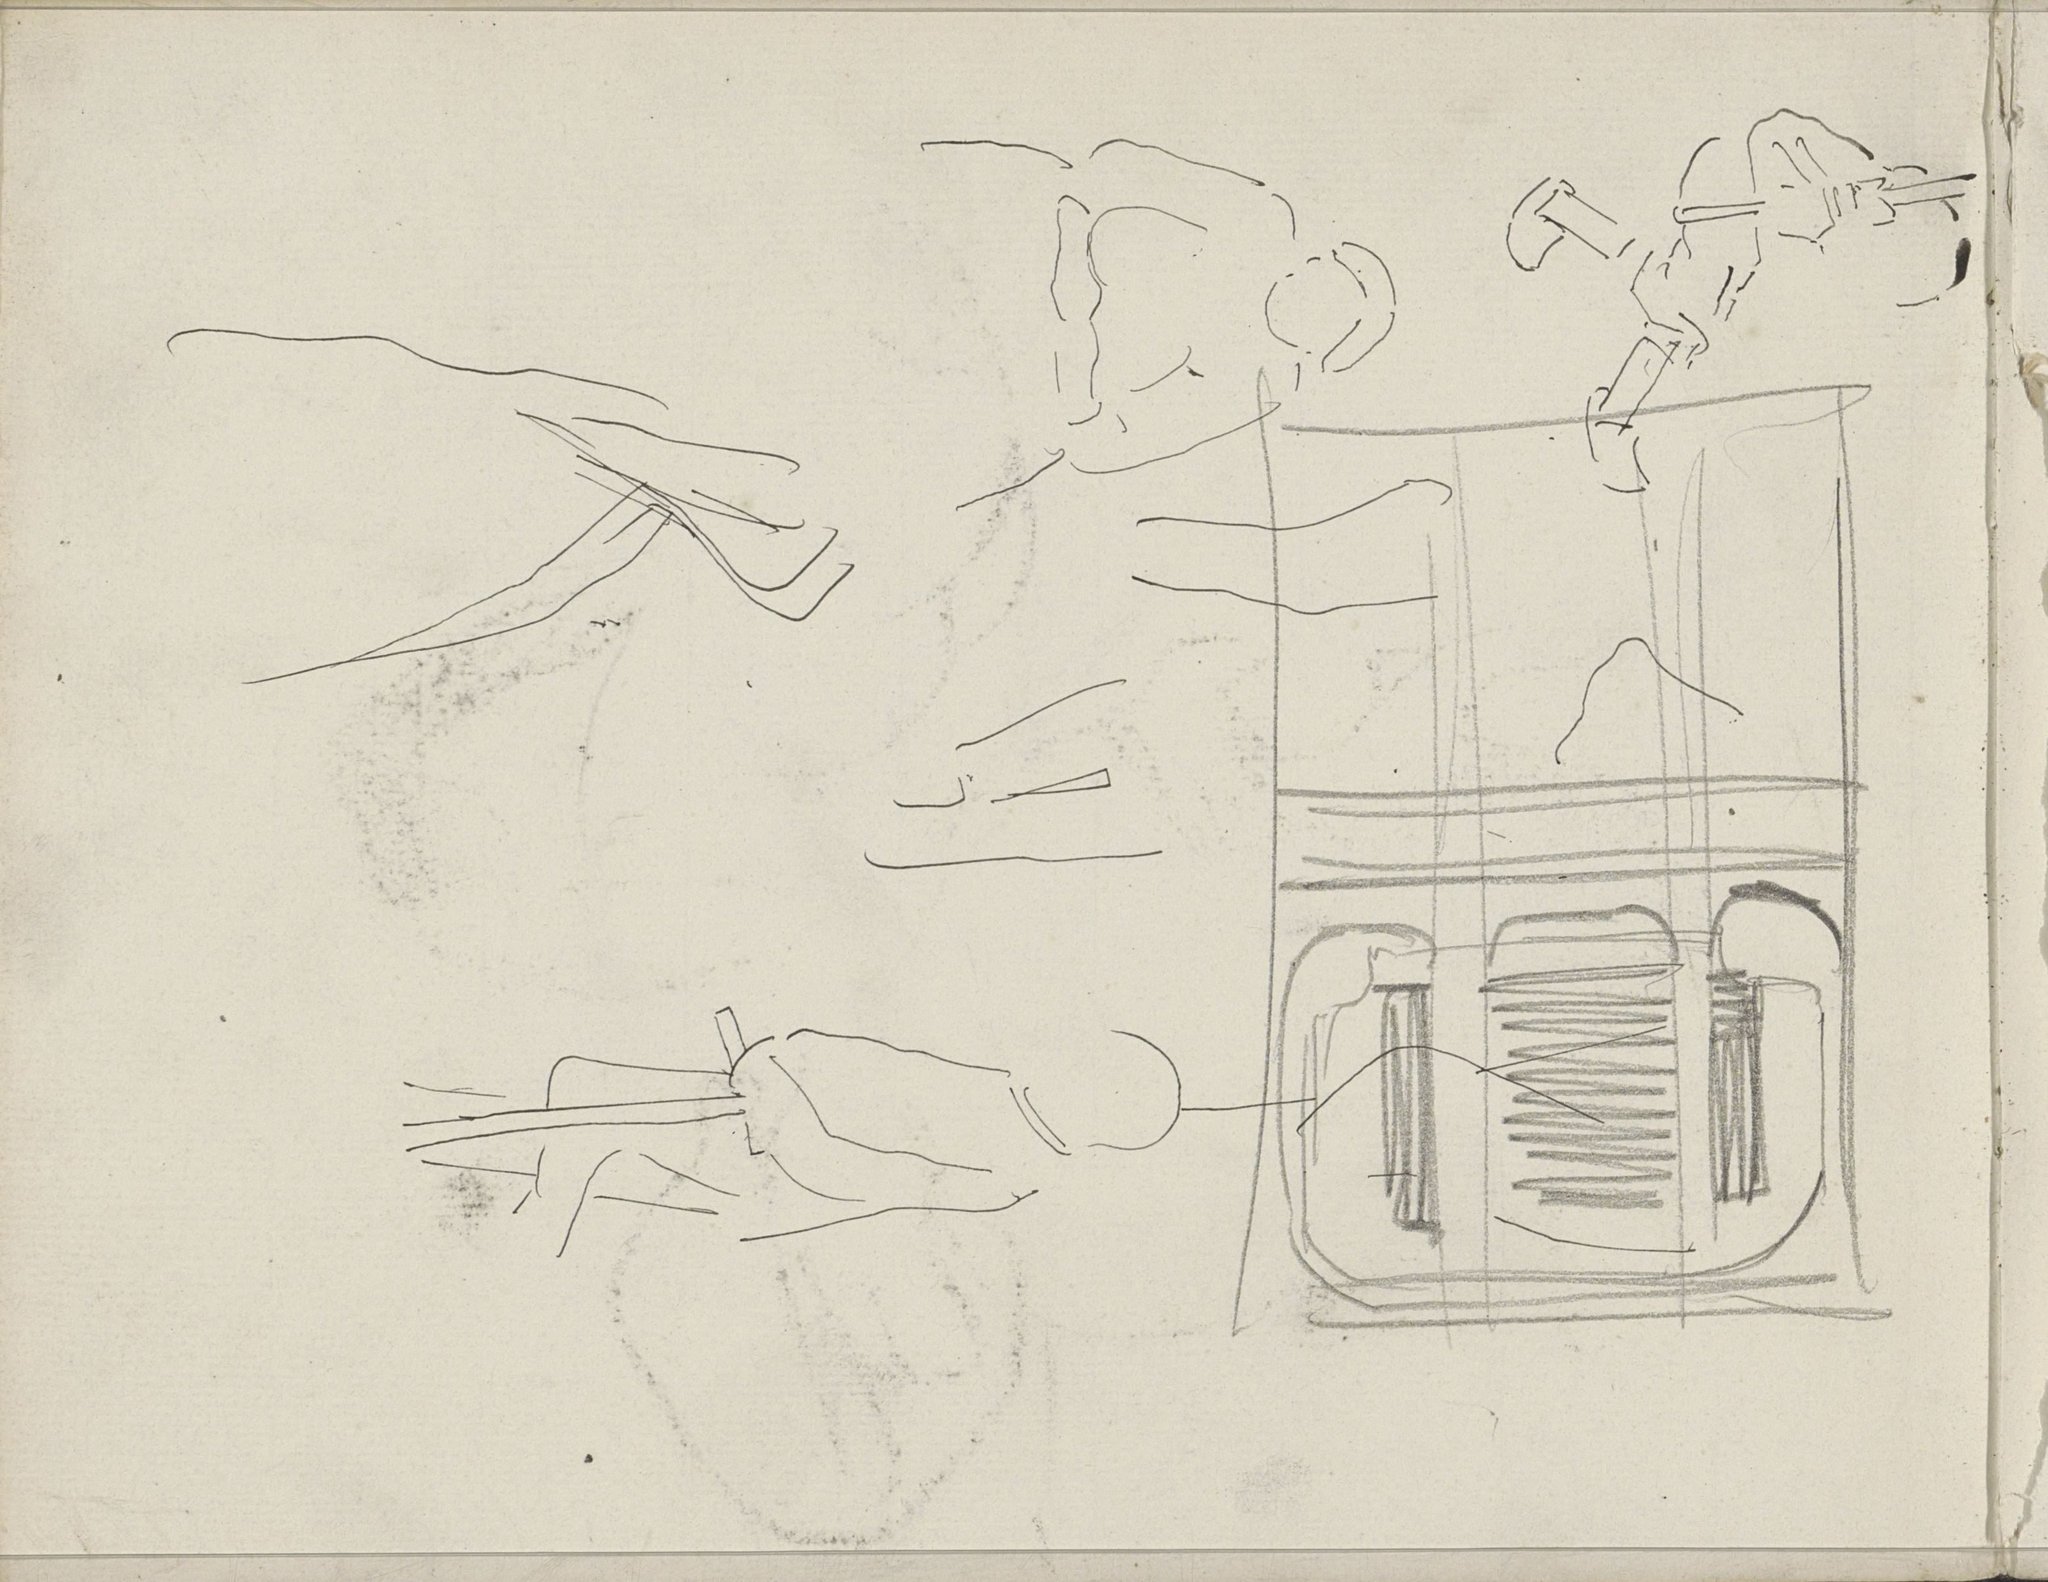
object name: sketchbook leaf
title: Studieblad, onder andere met figuurstudies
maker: carel adolph lion cachet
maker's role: draughtsman, print maker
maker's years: 1864-1945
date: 1896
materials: ink, paper, pencil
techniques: pen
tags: sitting figure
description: Blad 32 verso uit een schetsboek met 44 bladen.